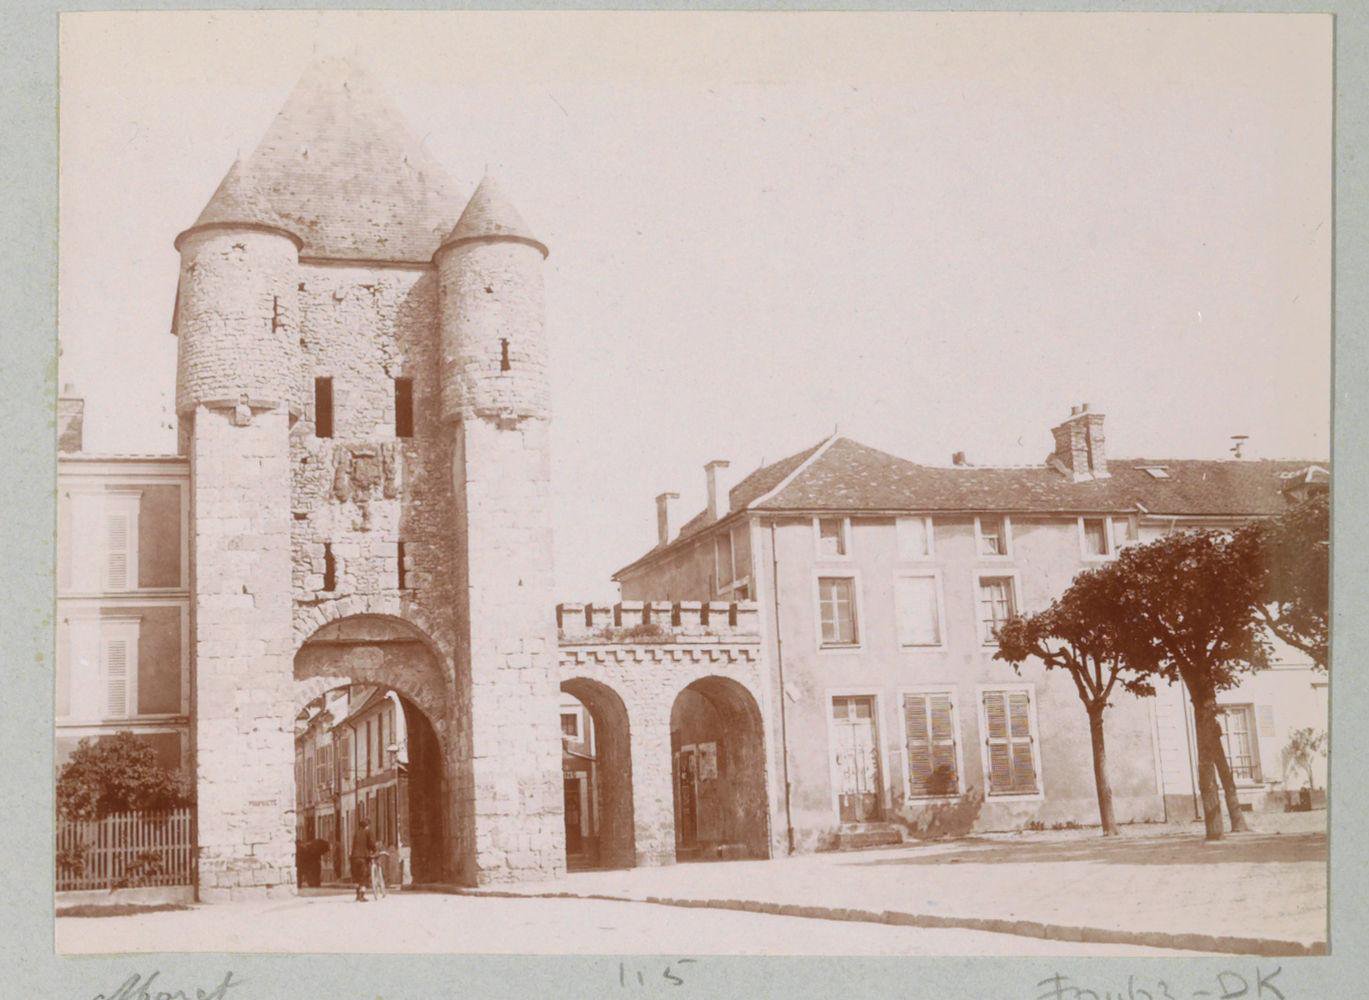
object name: photograph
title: Gezicht op de Porte de Samois in Moret-sur-Loing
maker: delizy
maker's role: manufacturer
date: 1897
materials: paper, photographic support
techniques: gelatin silver print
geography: moret-sur-loing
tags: gate ~ fortified city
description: Onderdeel van Fotoalbum van een Franse amateurfotograaf met opnames van uitstapjes in Frankrijk, Spanje, België, Luxemburg en Nederland, de eerste automobielen en autoraces.